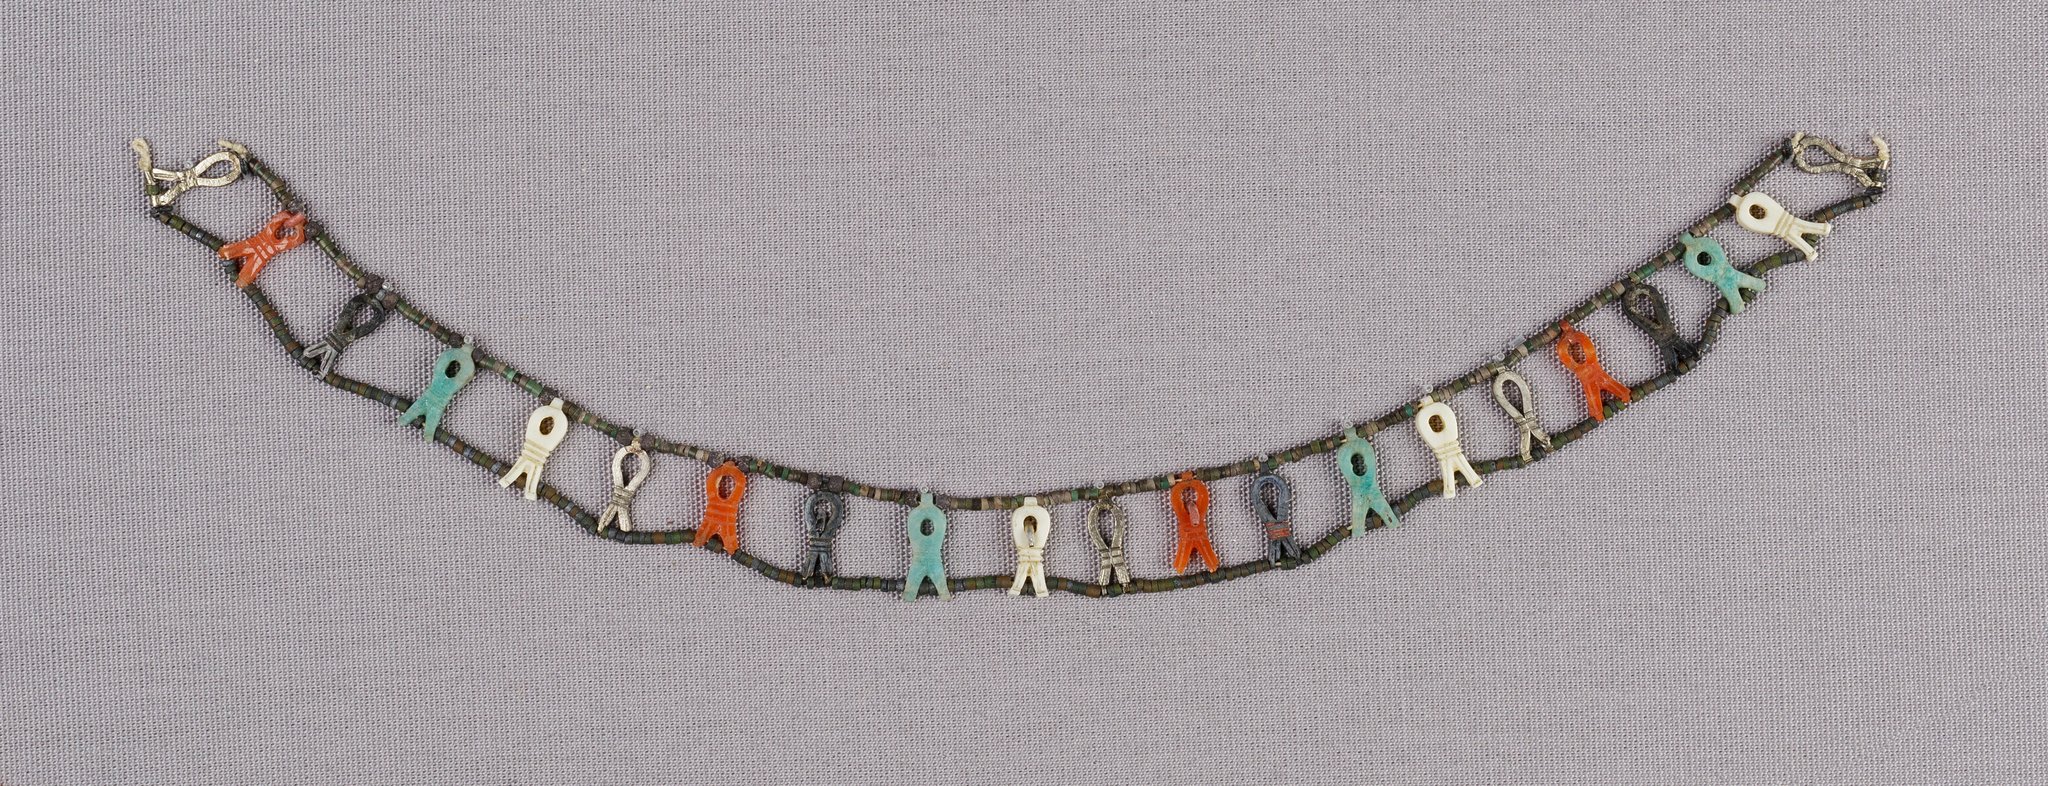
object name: necklace, sa amulet, senebtisi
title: Necklace with Sa-Amulets of Senebtisi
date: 1859-1770 BCE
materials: gemstone, ivory, silver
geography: egypt